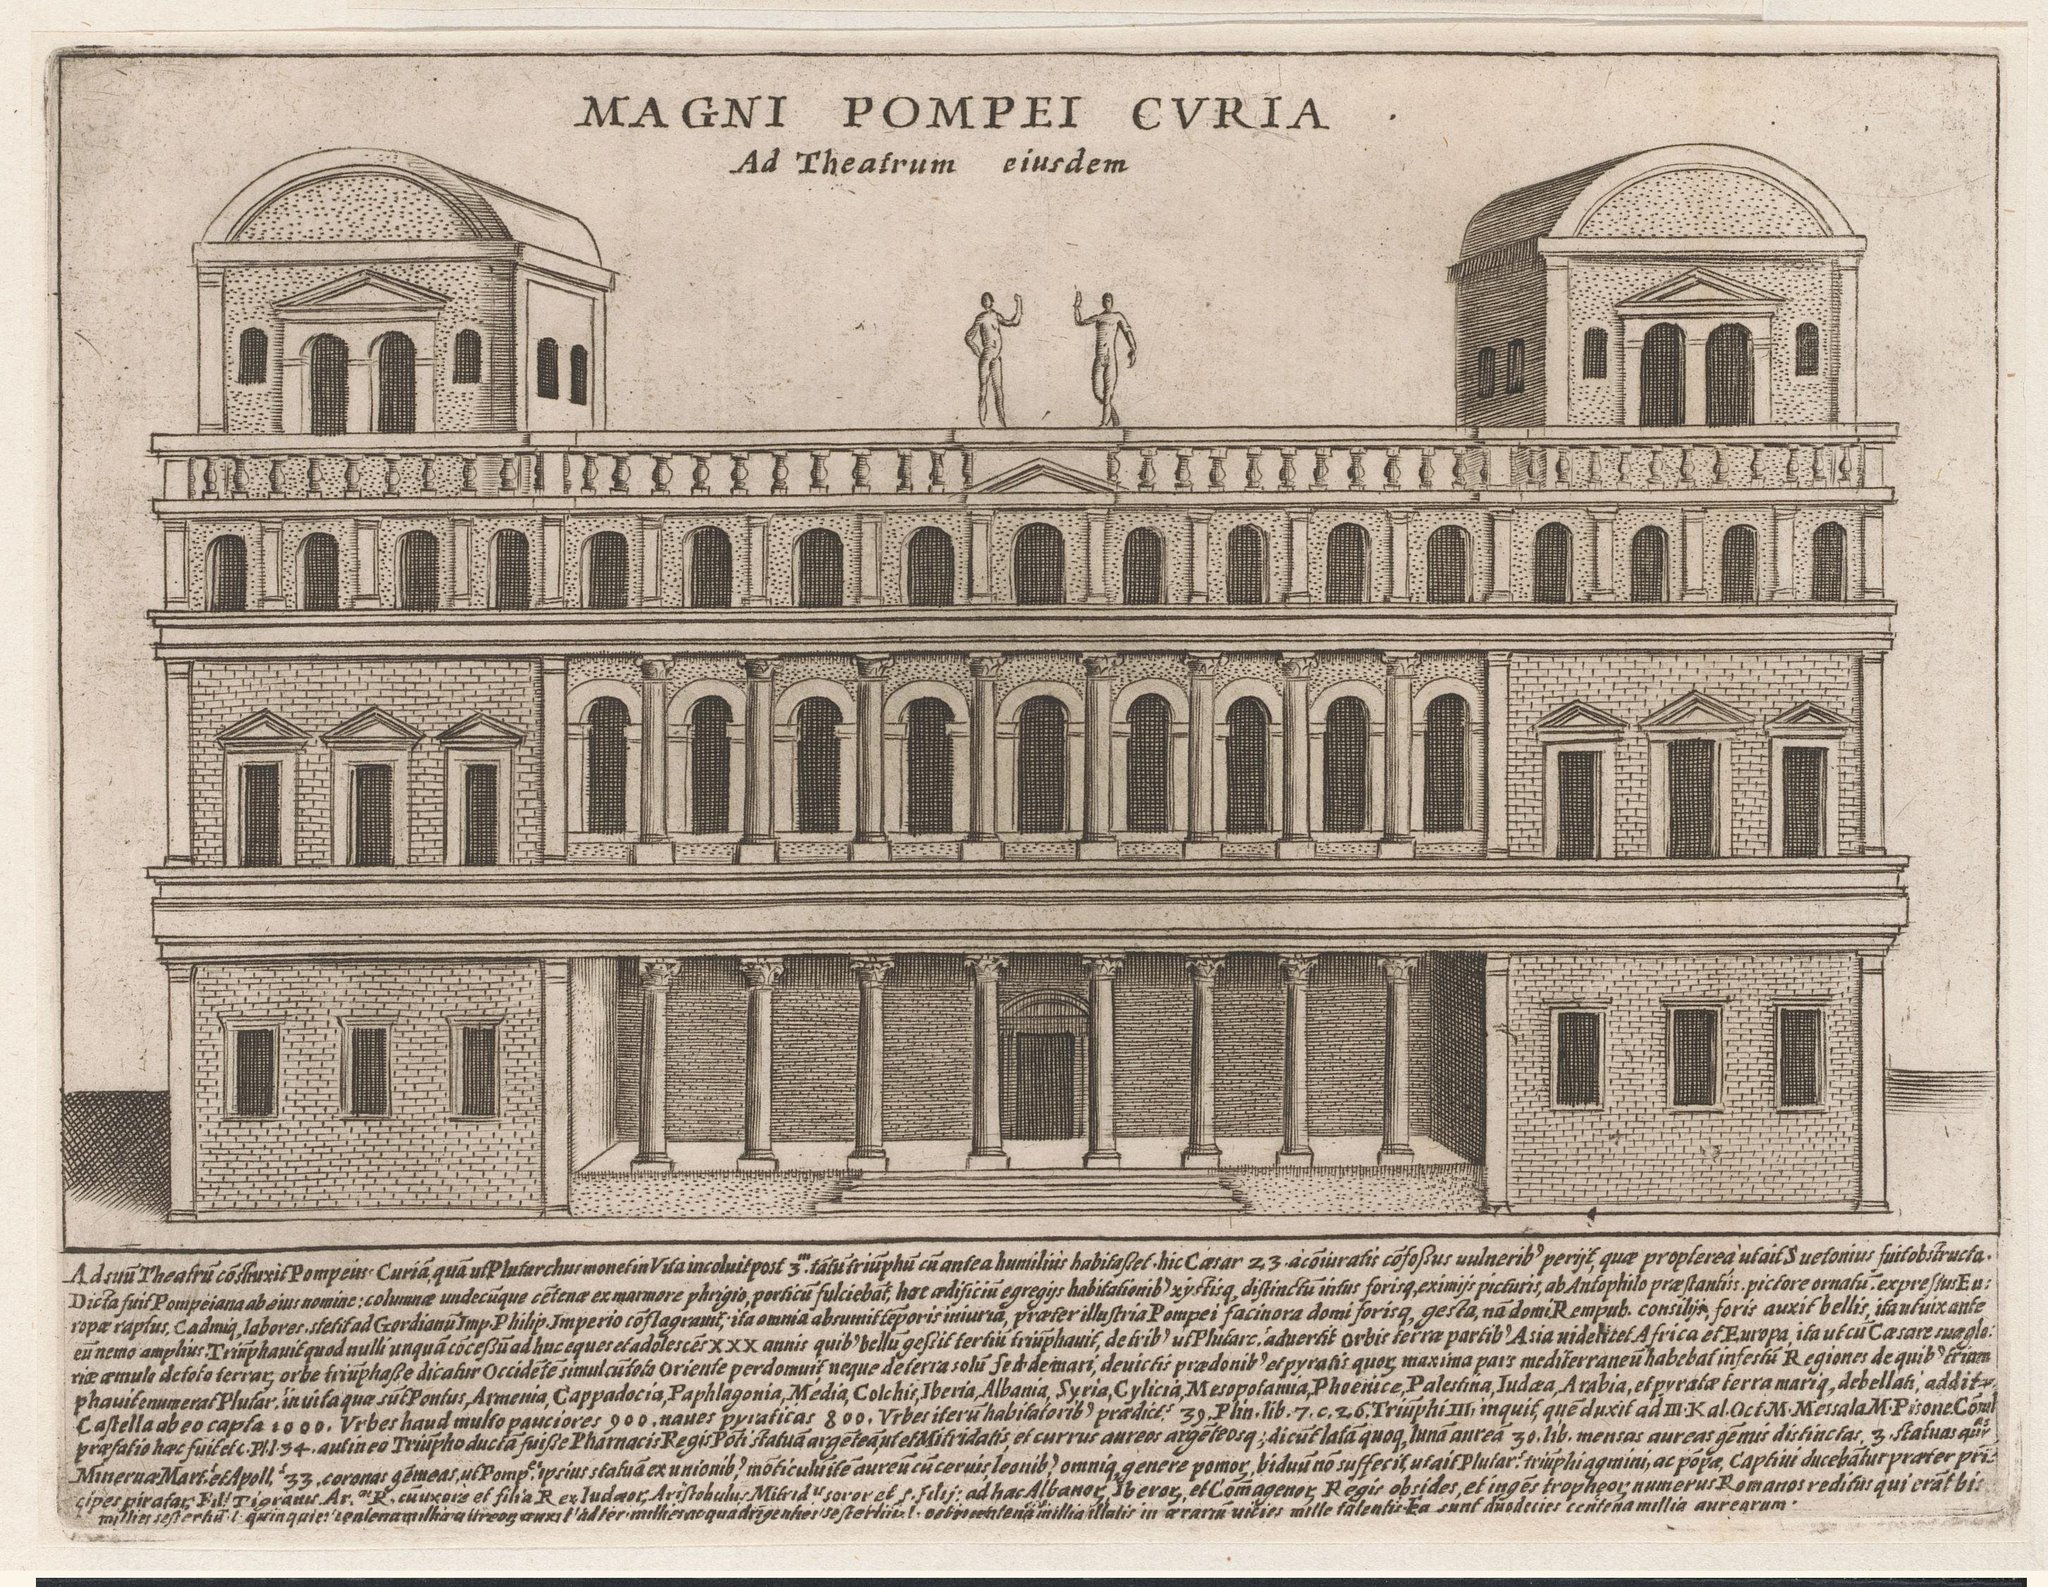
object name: album leaf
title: Curia Pompeia te Rome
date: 1612-1628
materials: paper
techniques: etching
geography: rome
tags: representation of real building (either existing or having existed)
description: Deze prent maakt deel uit van een set van 158 prenten (+ titelprenten), die verscheen in vier delen. In 1612 verschenen delen één en twee. In 1615 verscheen het derde deel en in 1628 verscheen deel vier. In 1637 publiceerde Vitale Mascardi de eerste heruitgave van de gehele set met nummering.